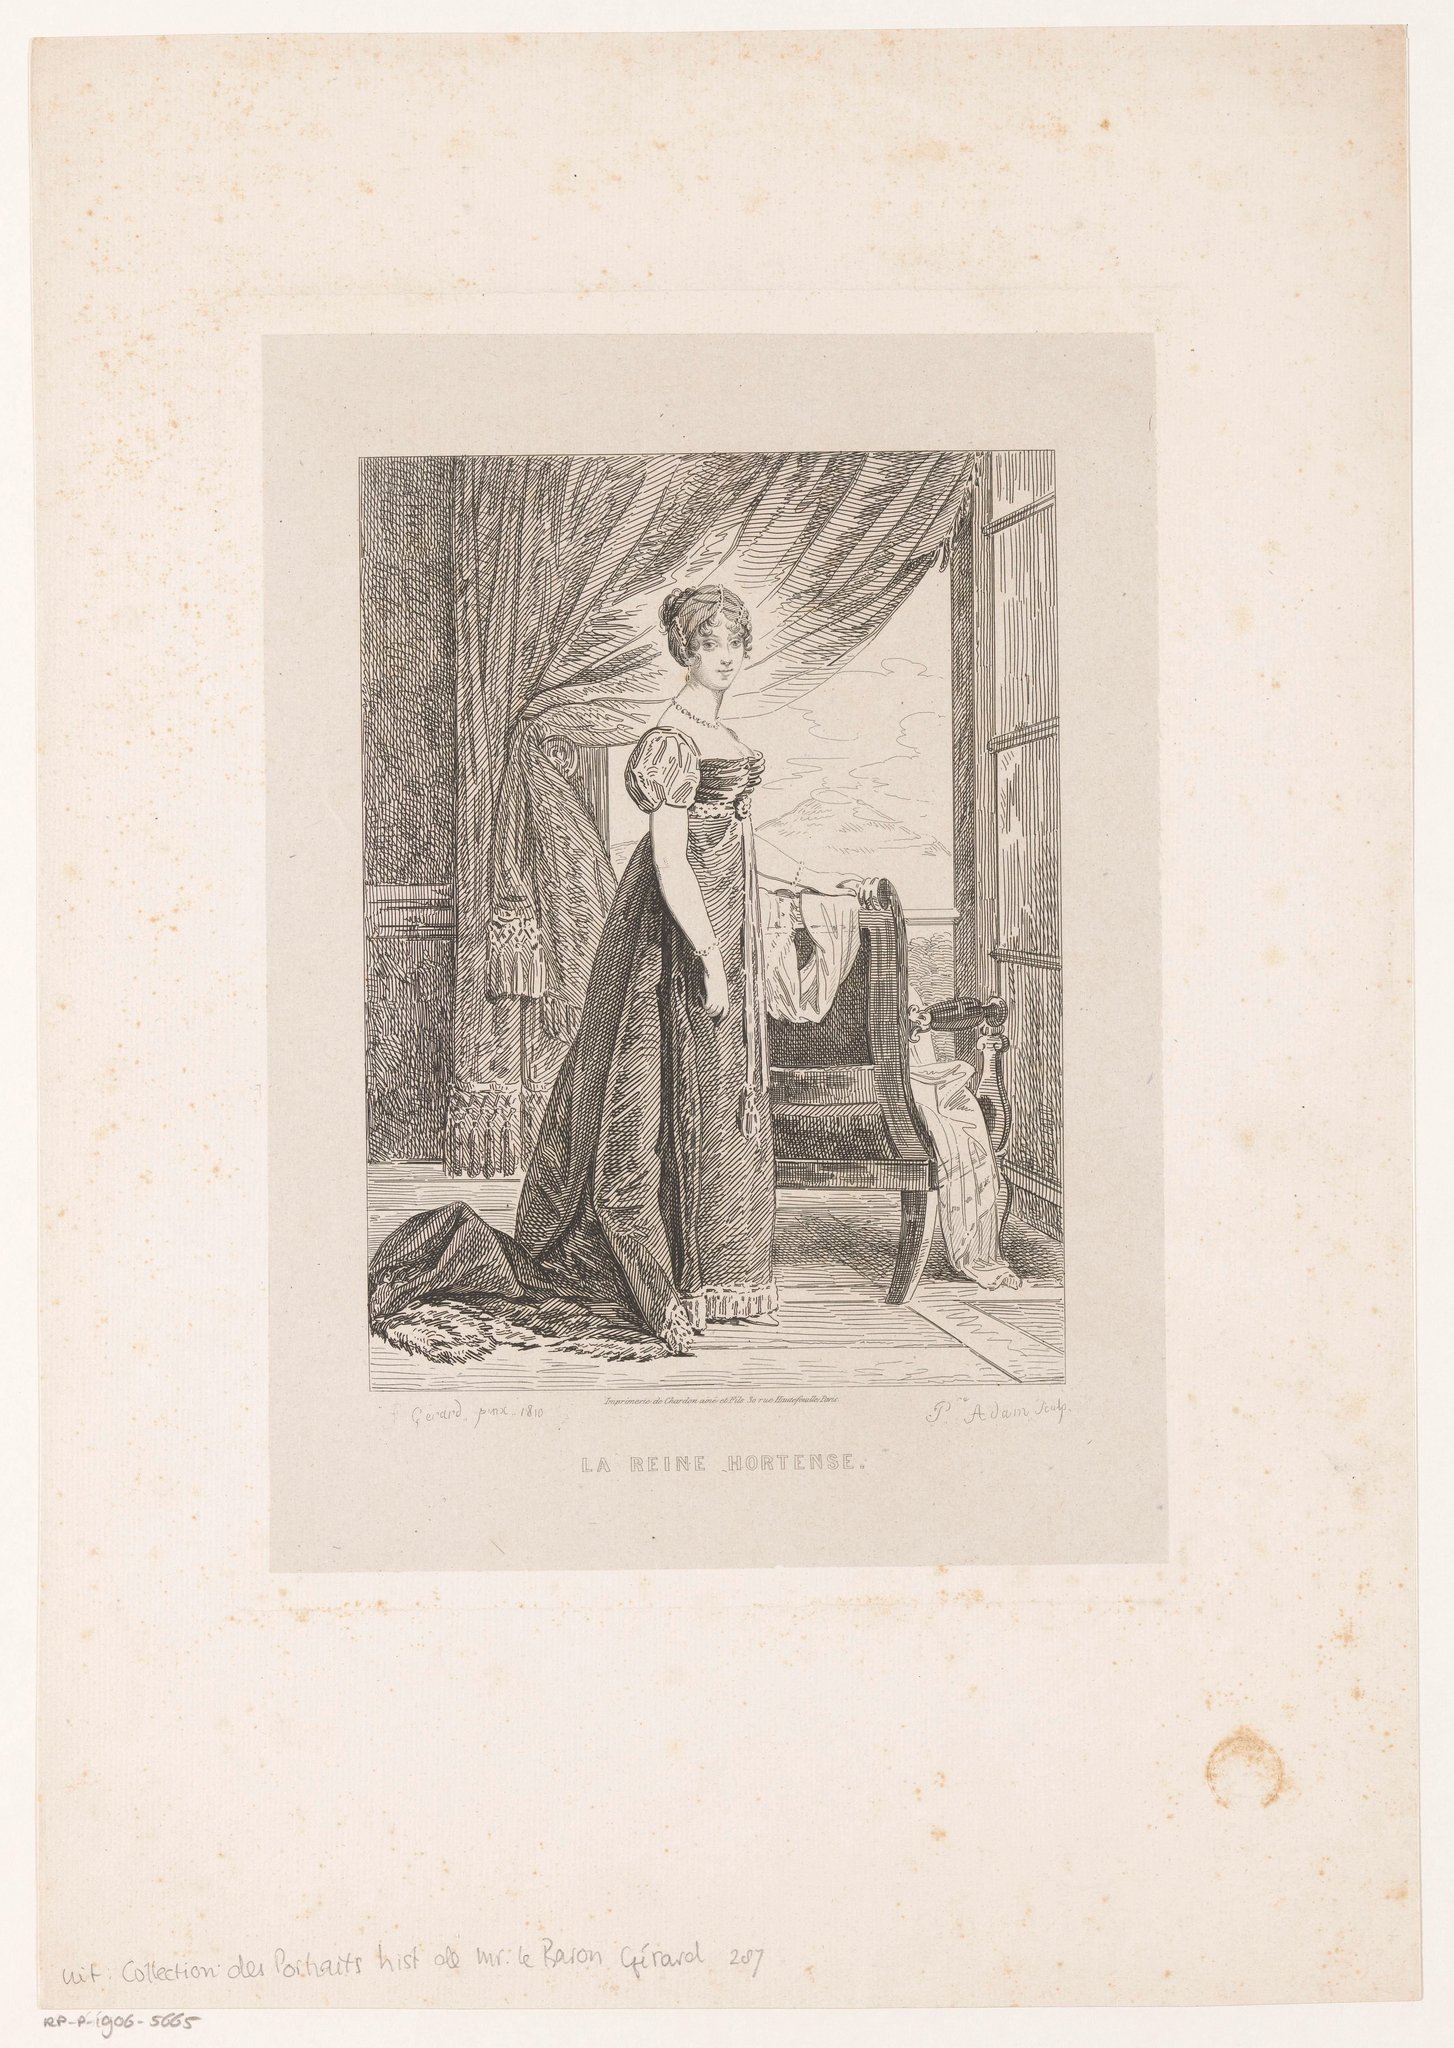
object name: print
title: Collectie van historische portretten van Baron Gérard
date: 1825-1828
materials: paper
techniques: etching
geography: paris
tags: paris, historical persons, standing figure - aa - female human figure, chair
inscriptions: check stamp: ‘1789 / 1836’, collector's mark: Lugt 2228